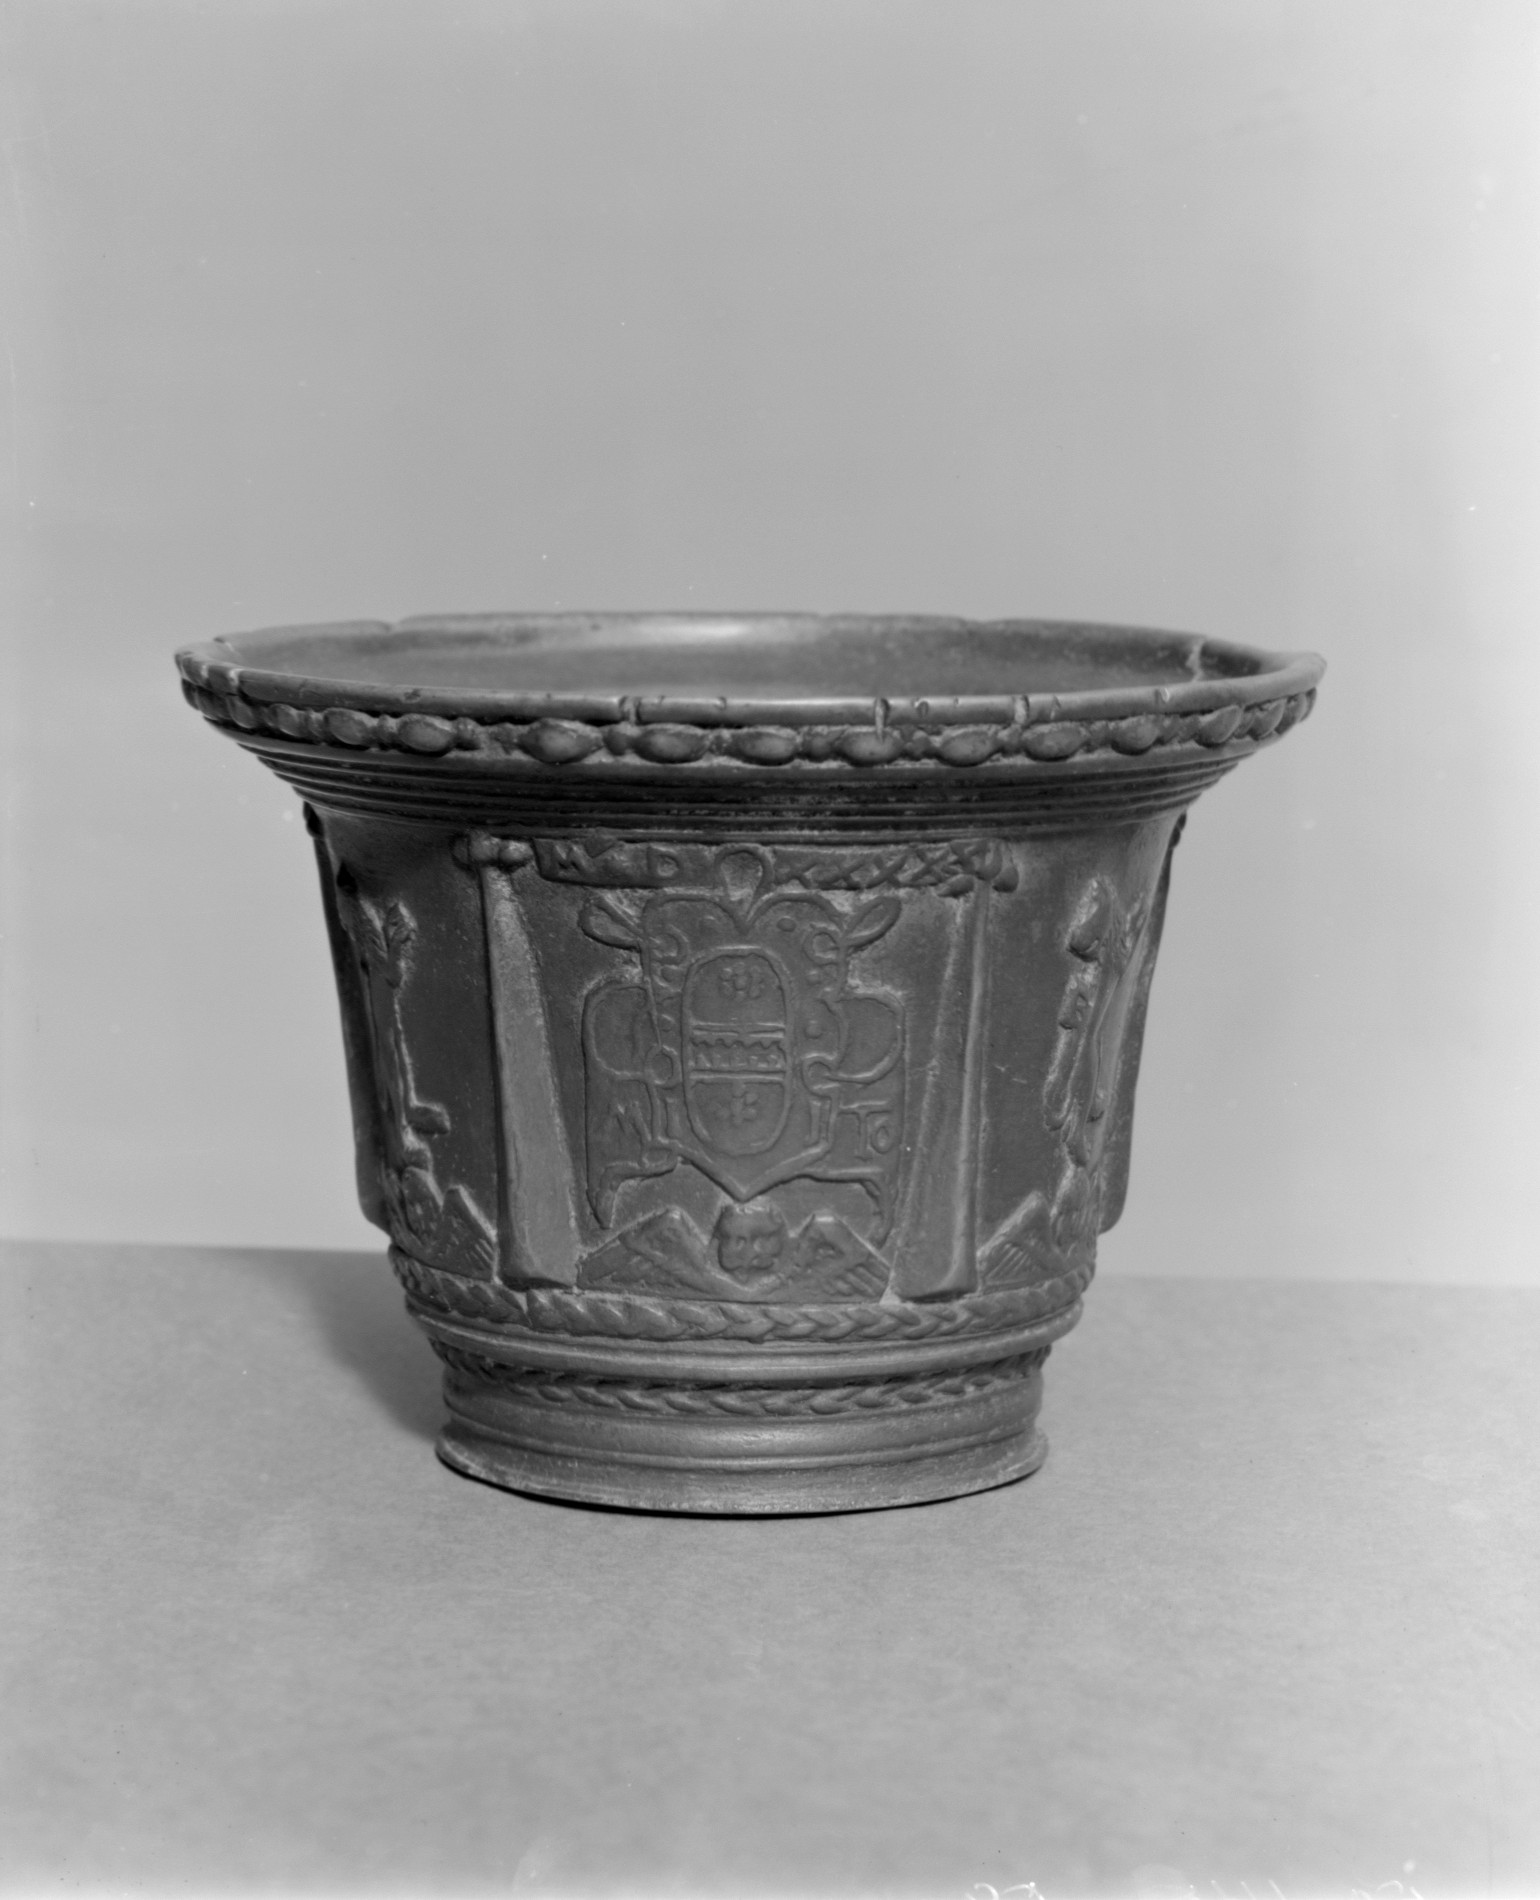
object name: mortar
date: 1550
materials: bronze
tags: coat of arms